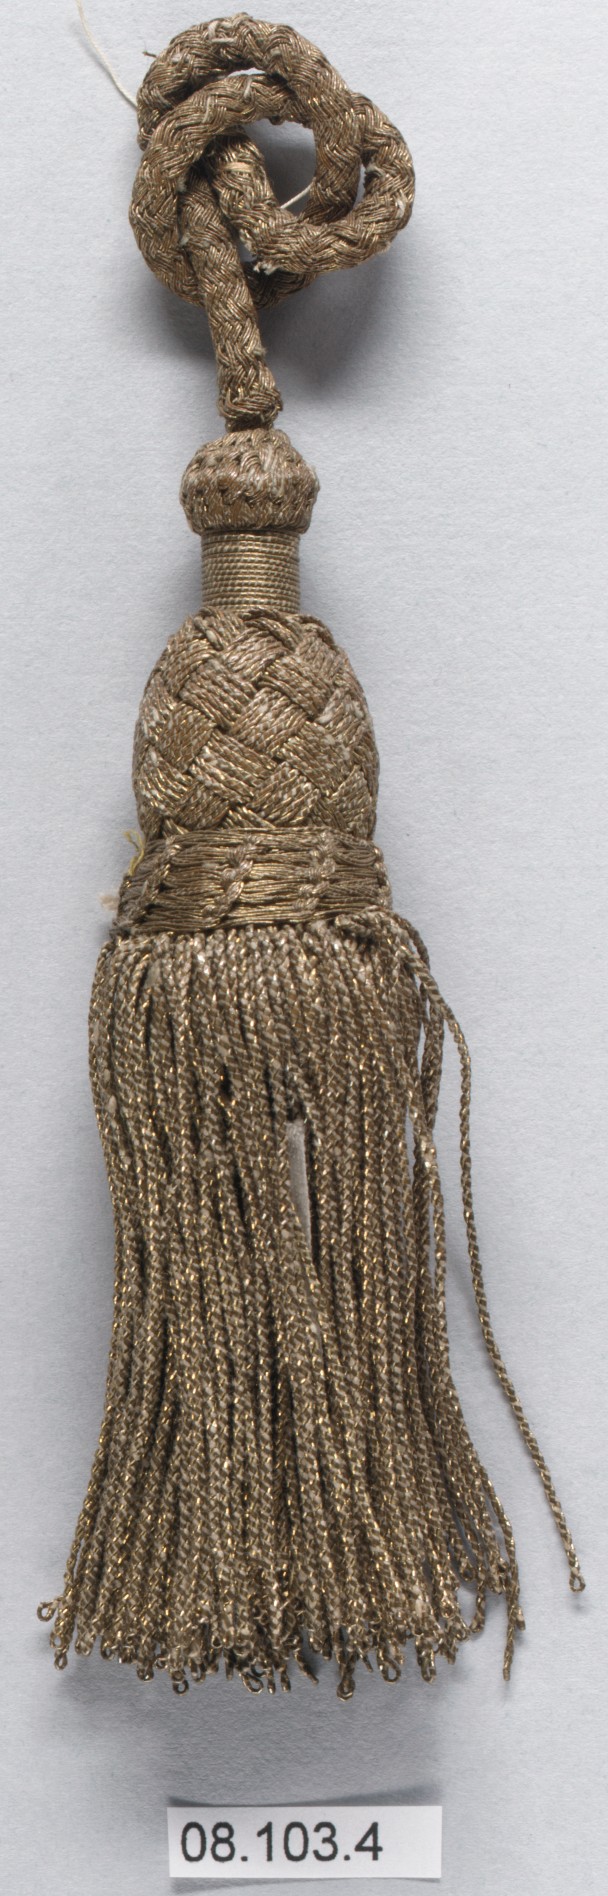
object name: tassel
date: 1701-1800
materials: metal thread